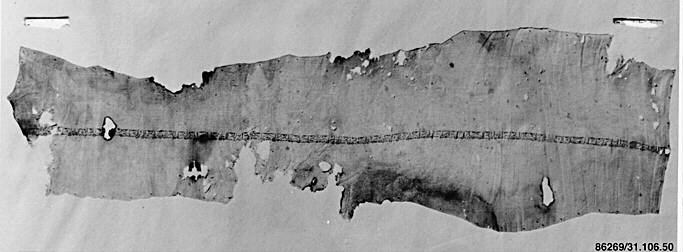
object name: textile fragment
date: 1035-1094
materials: linen, silk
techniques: weave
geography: egypt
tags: arabic